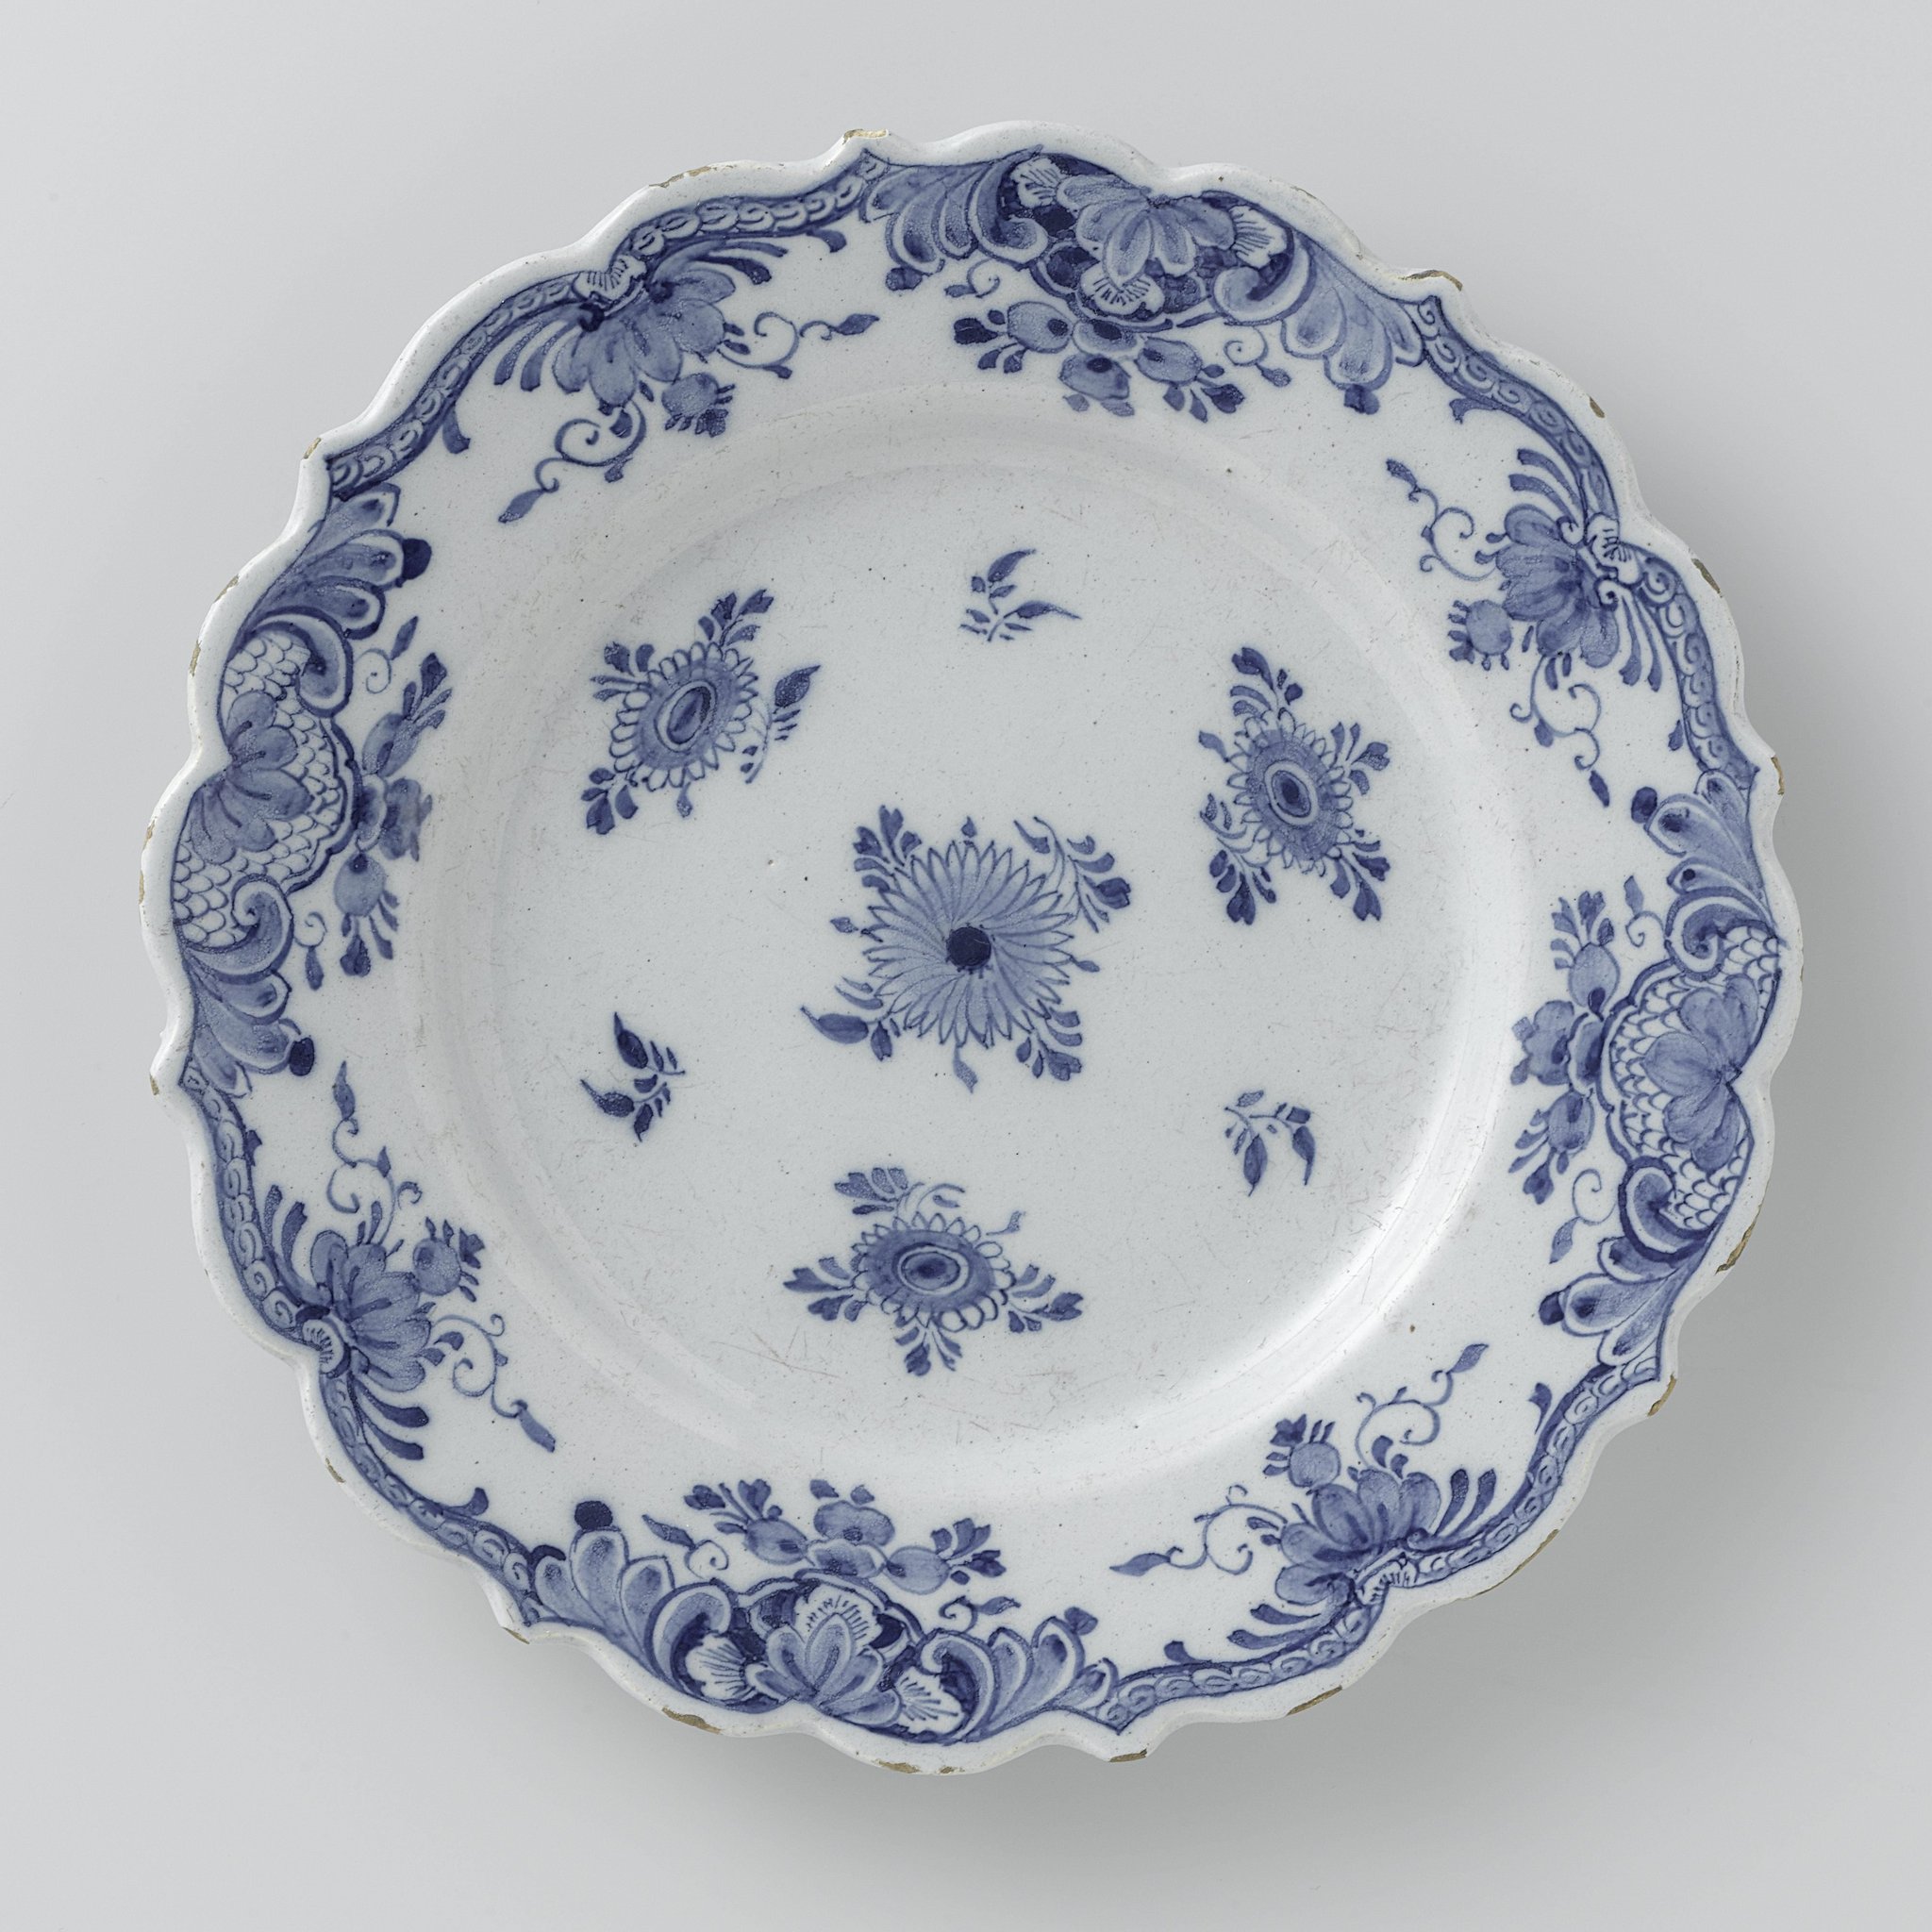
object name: plate dish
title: Bord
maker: johannes van duijn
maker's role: plateelbakker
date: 1764-1773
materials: faience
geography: delft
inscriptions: mark: ‘IVDuijn’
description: Bord van faience. Blauw beschilderd met bloemdecoratie.